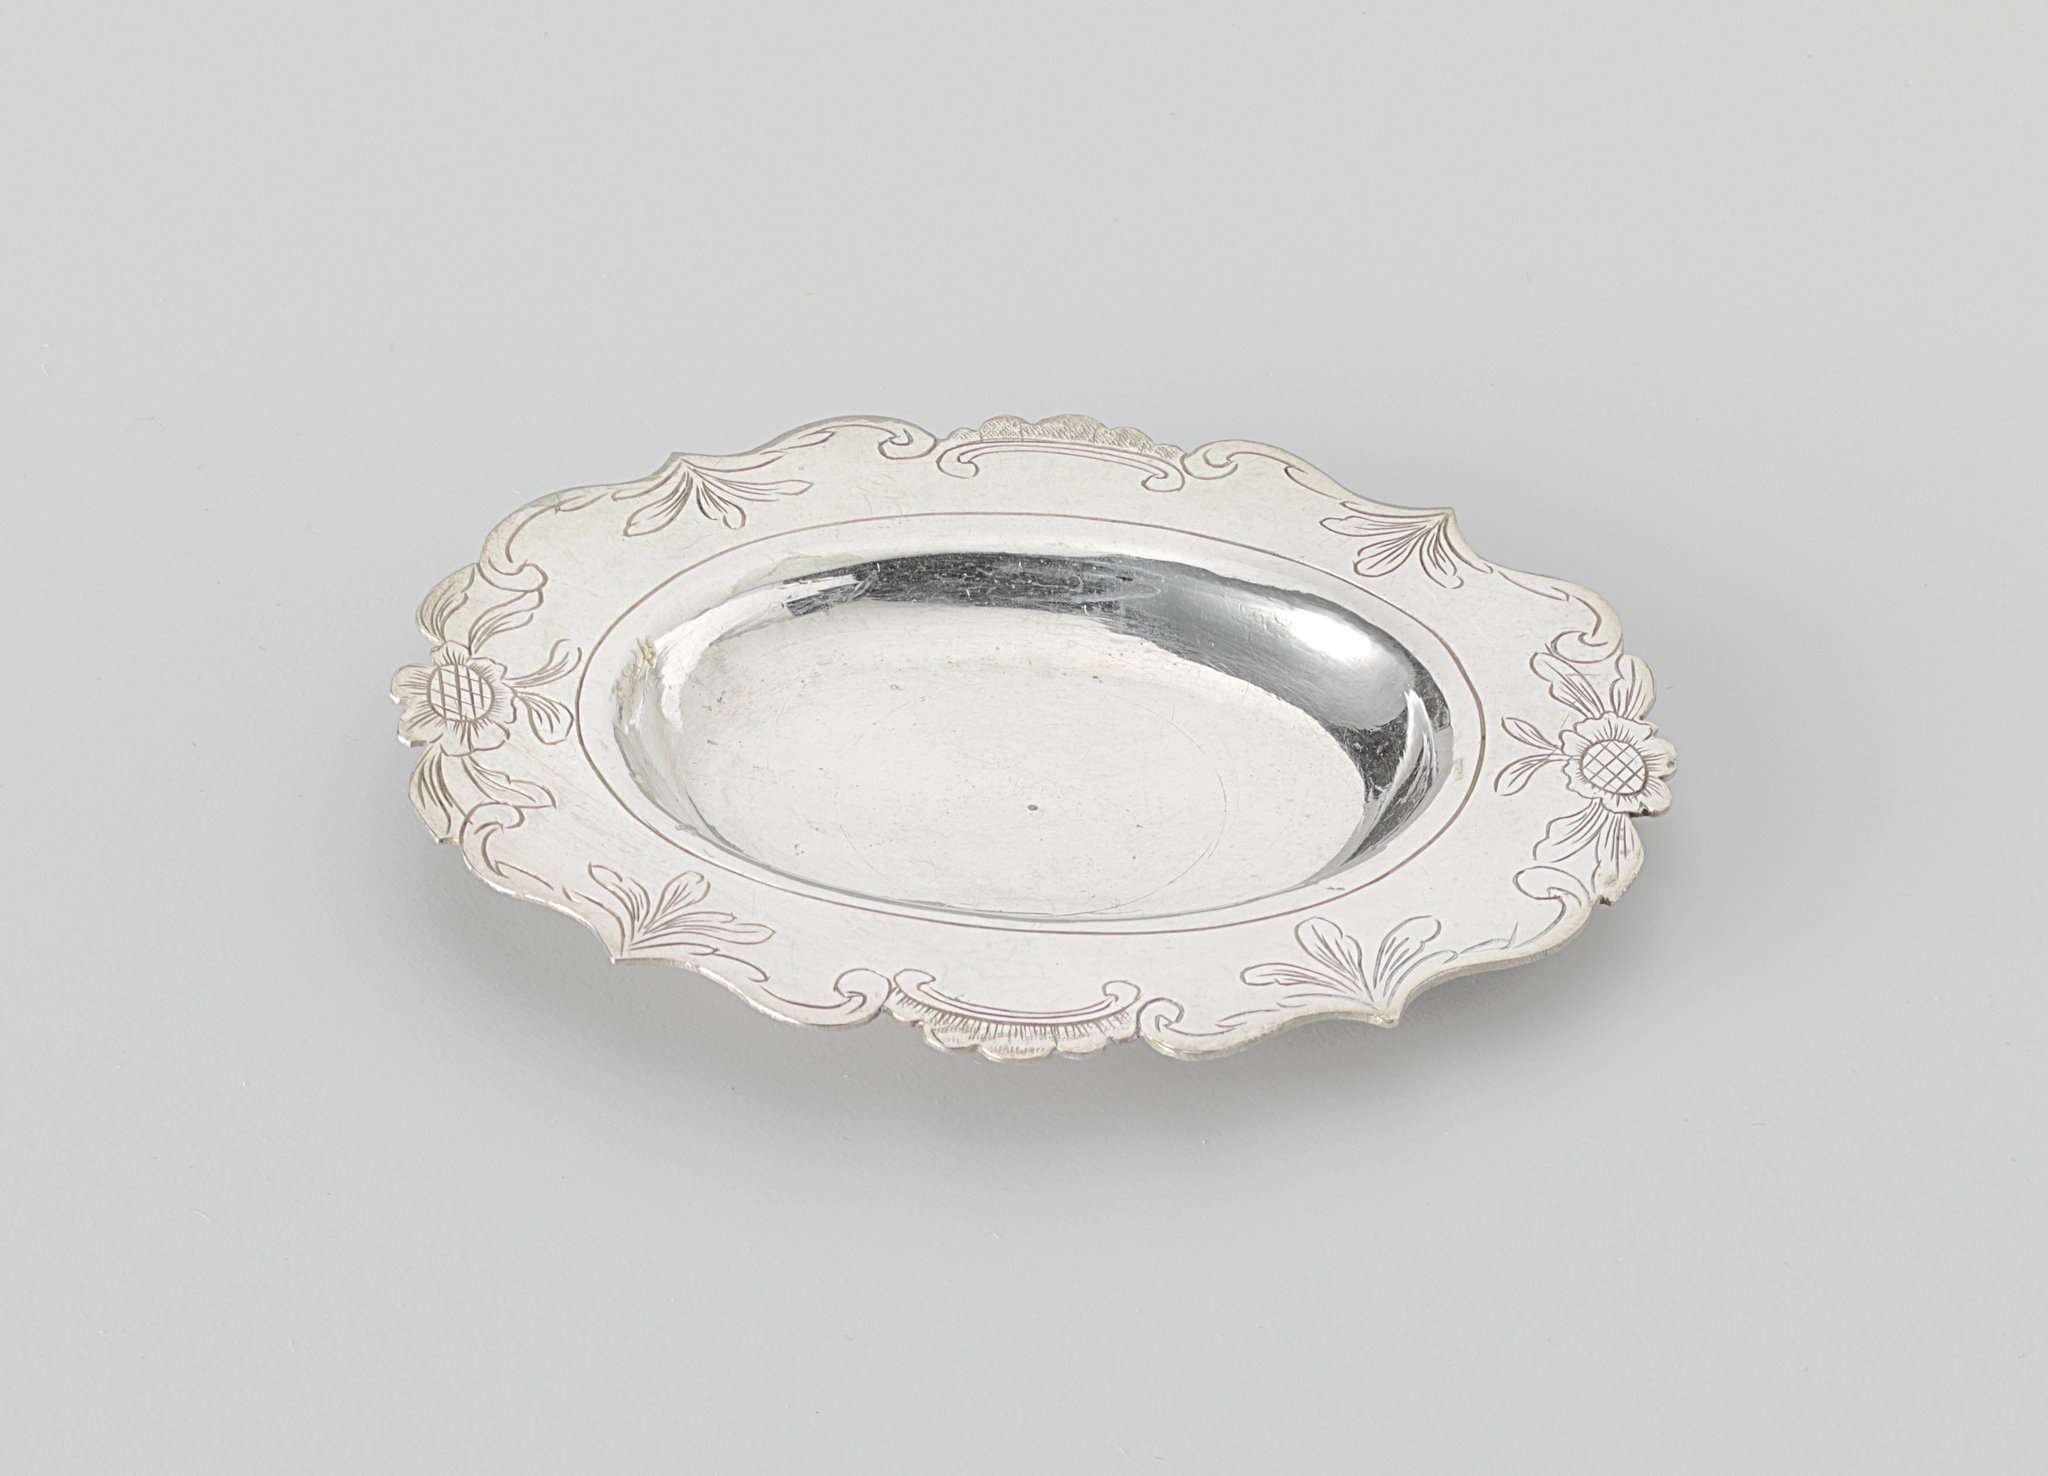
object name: miniature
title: Schotel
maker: Anonymous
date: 1781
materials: silver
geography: amsterdam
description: Ovale schotel met geschulpte rand. In de rand zijn rocaille elementen, bladeren en bloemen gegraveerd. De schotel is gemerkt: stk.= Amsterdam, jrl.= W (1781) en een onbekend meesterteken.